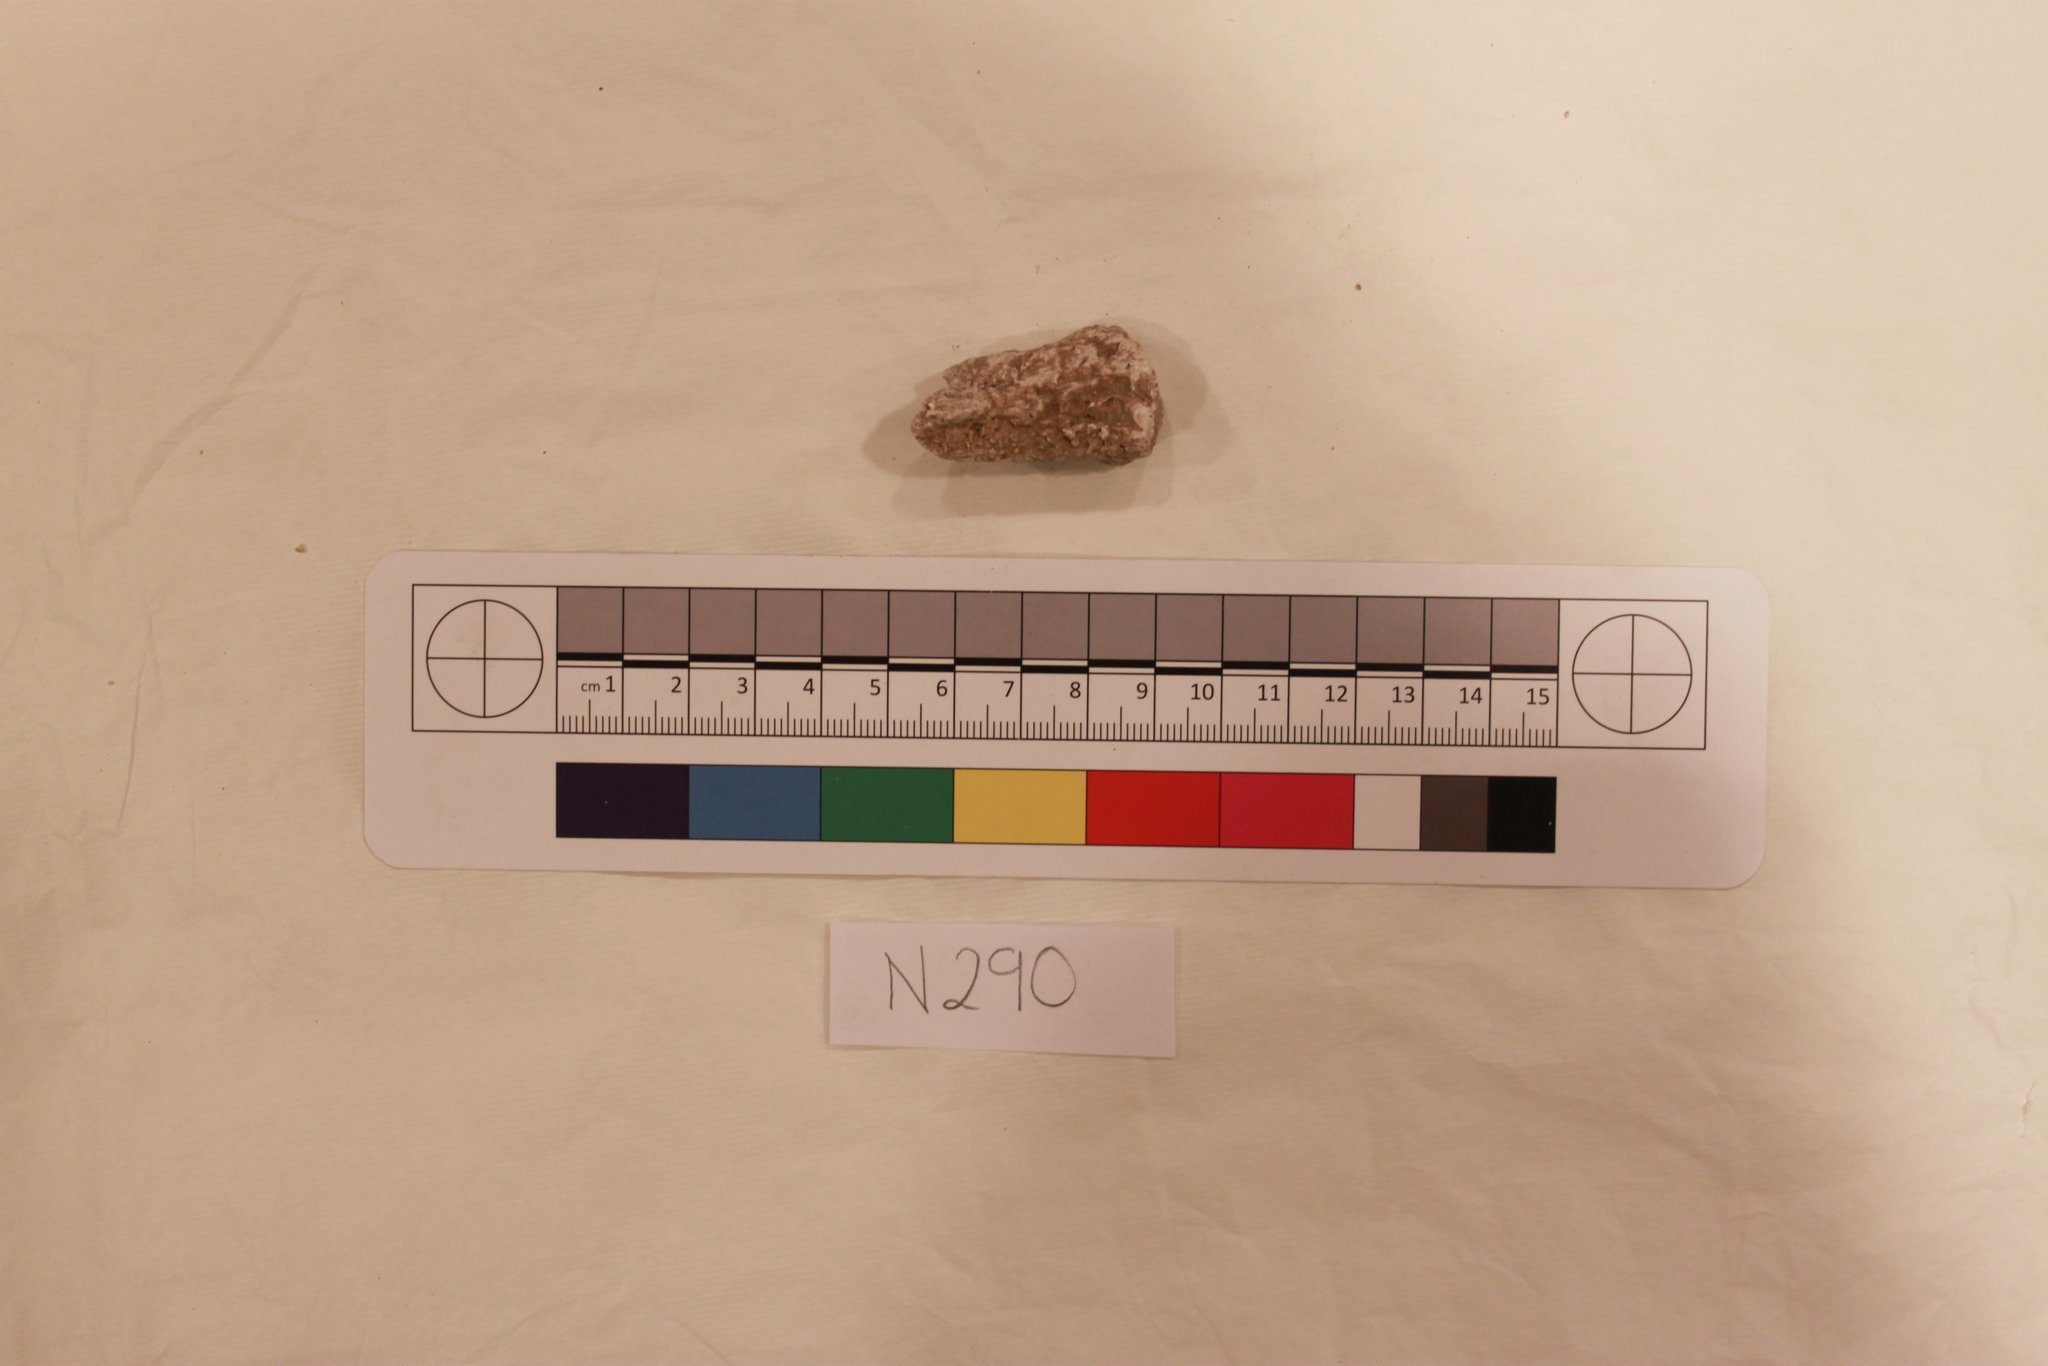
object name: fragment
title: Stucco Fragment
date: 701-1200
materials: plaster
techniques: carving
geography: iran